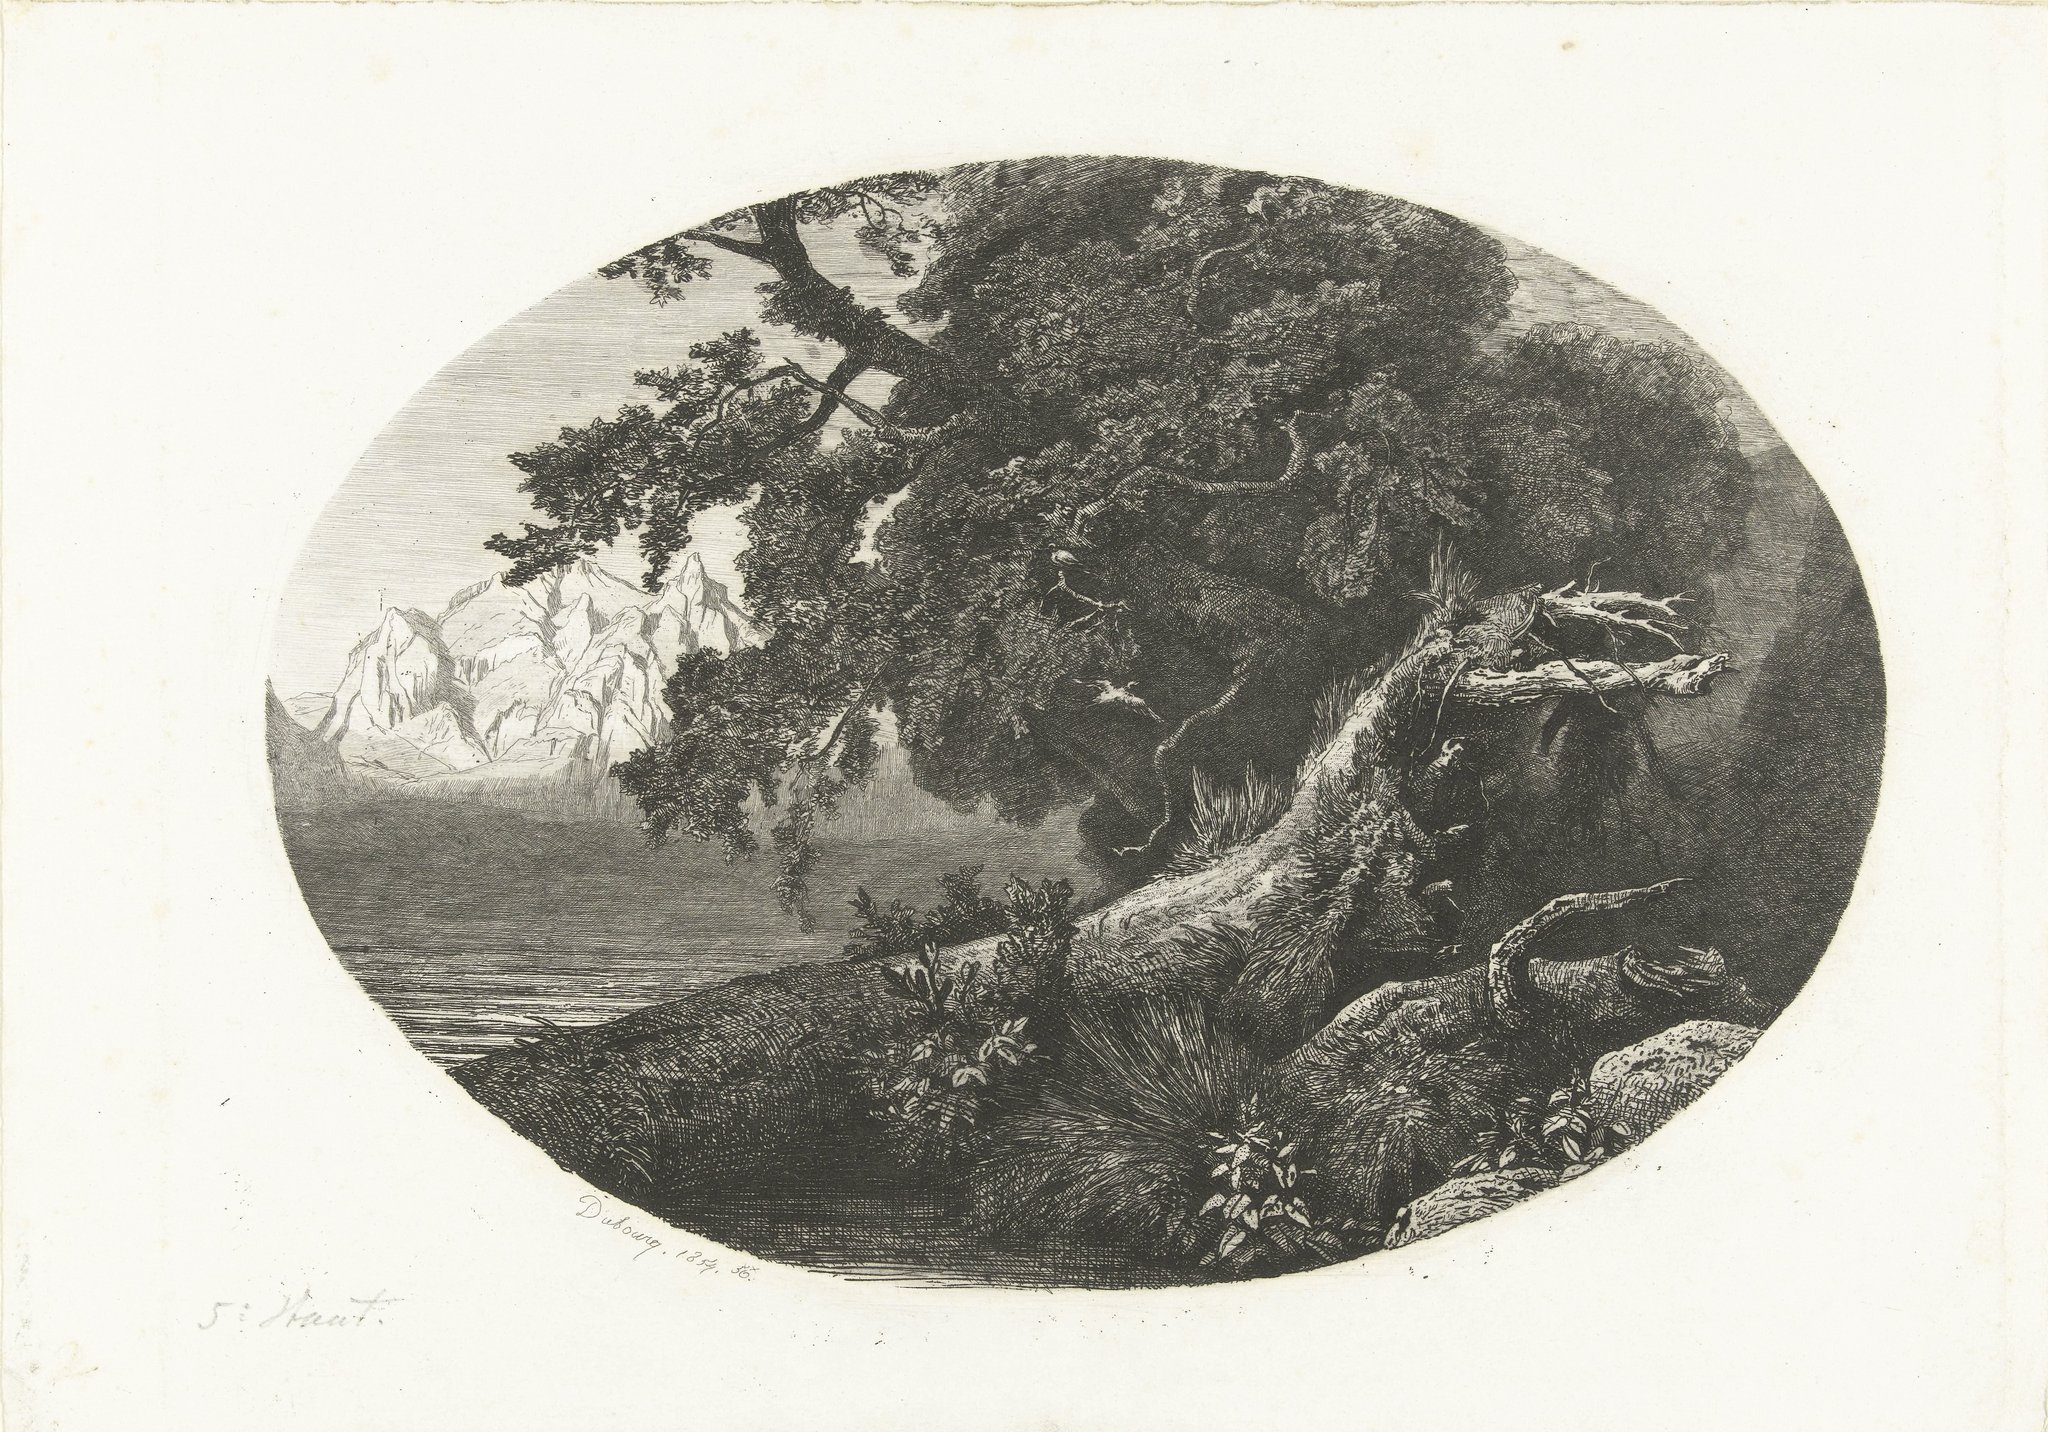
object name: print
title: Ontwortelde boomstam aan de kust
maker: pierre louis dubourcq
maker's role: draughtsman, painter, print maker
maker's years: 1815-1873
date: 1854-1856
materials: paper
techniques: drypoint, etching, roulette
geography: netherlands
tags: groups of trees, mountain-range, snow peaks, coast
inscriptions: collector's mark: Lugt 2228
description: Aan de kust van een meer ligt een ontwortelde boomstam. Aan de overkant zijn sneeuwbedekte bergtoppen te zien.